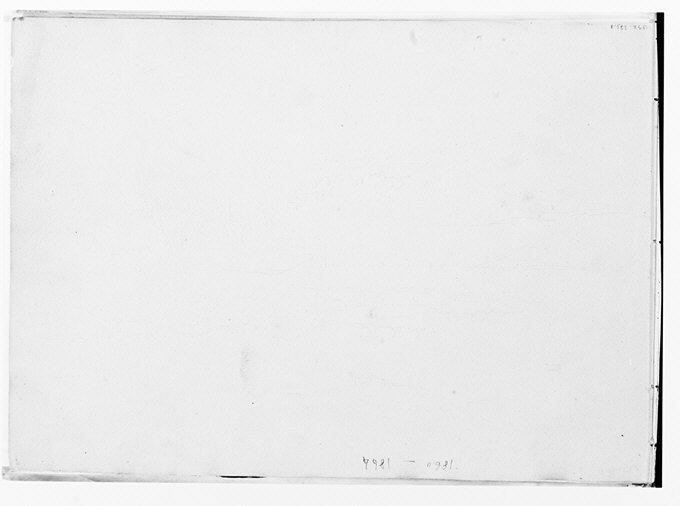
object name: drawing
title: Mountain Panorama (from Sketchbook)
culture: american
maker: thomas hewes hinckley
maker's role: artist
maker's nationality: american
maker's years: 1813-1896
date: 1860-1864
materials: graphite, paper